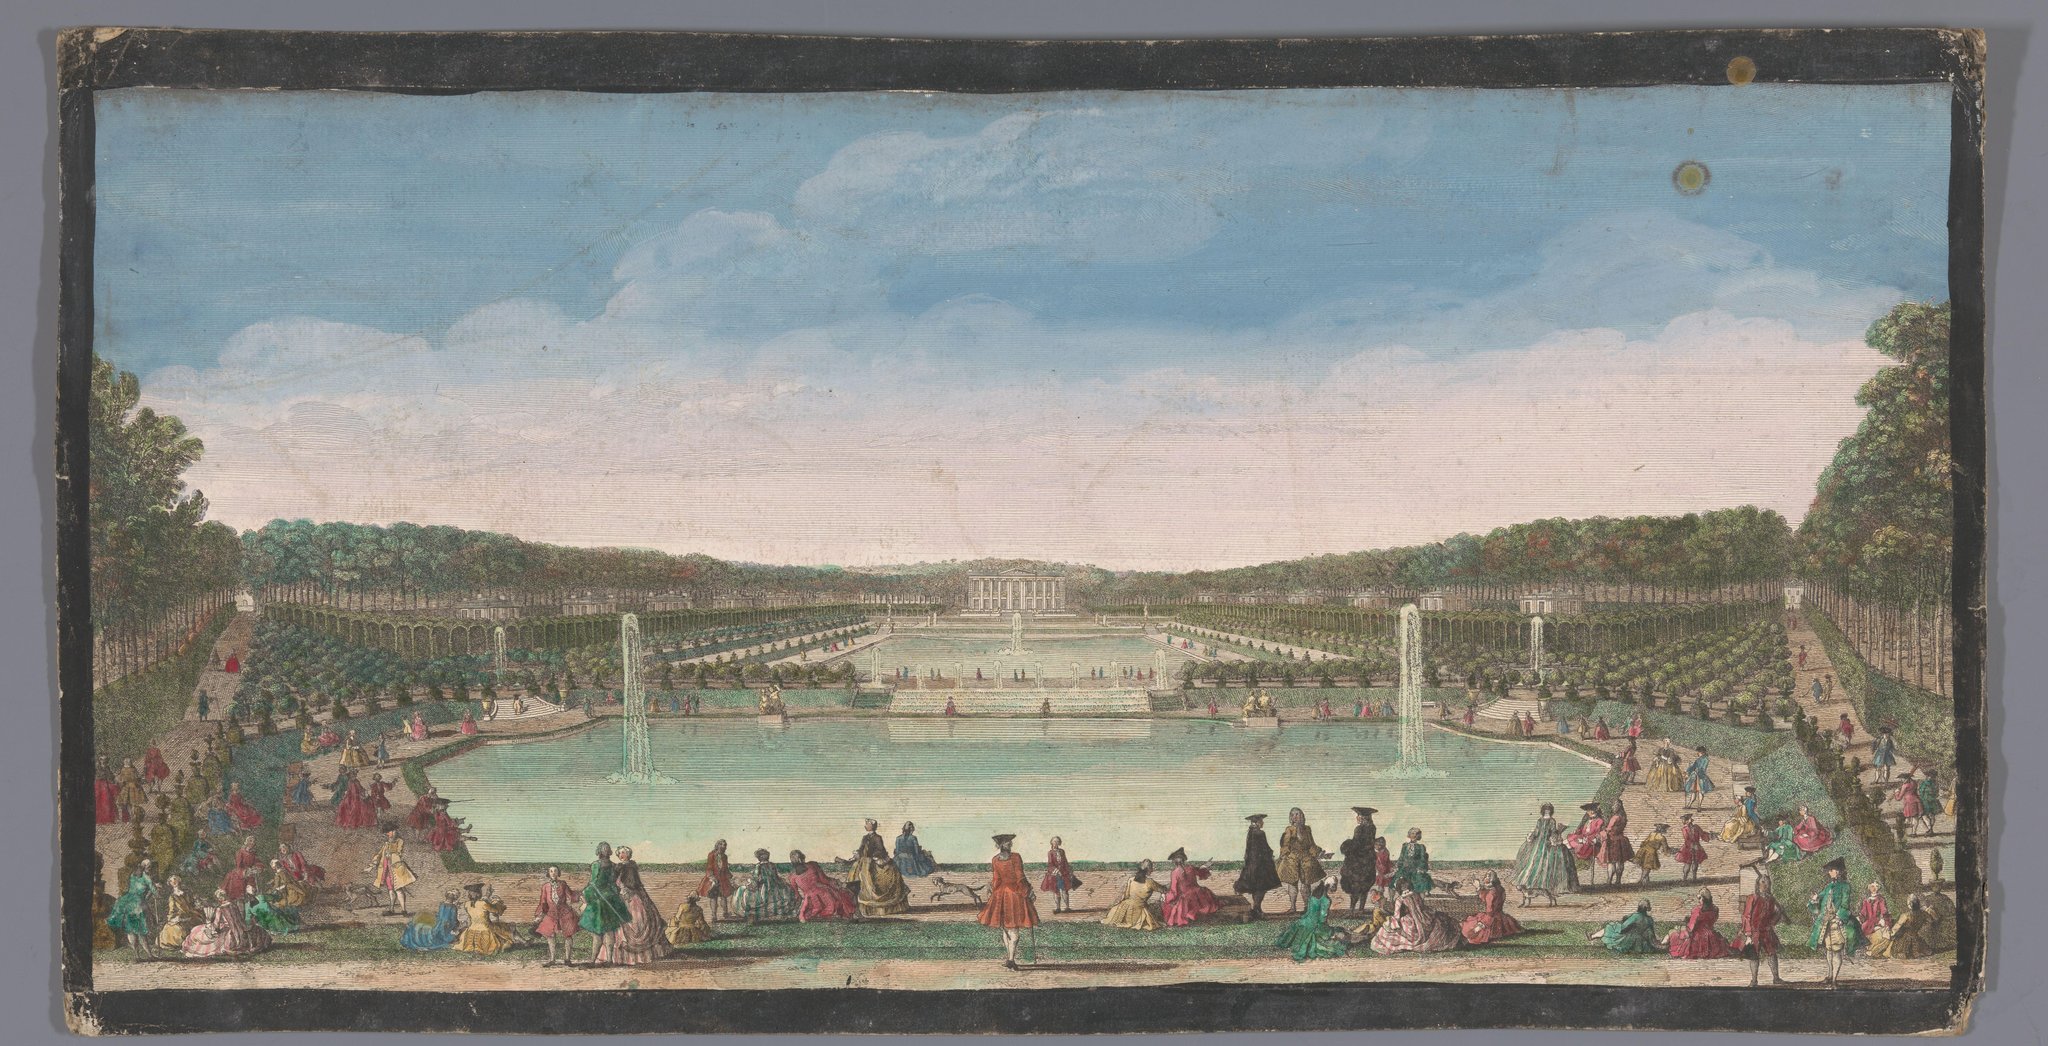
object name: print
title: Vue du Chateau de Marli prise du bas du grand parterre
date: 1700-1799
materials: cardboard, paper, watercolor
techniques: brush, etching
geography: paris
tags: civic architecture; edifices; dwellings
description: In de ondermarge twee regels Franse tekst.